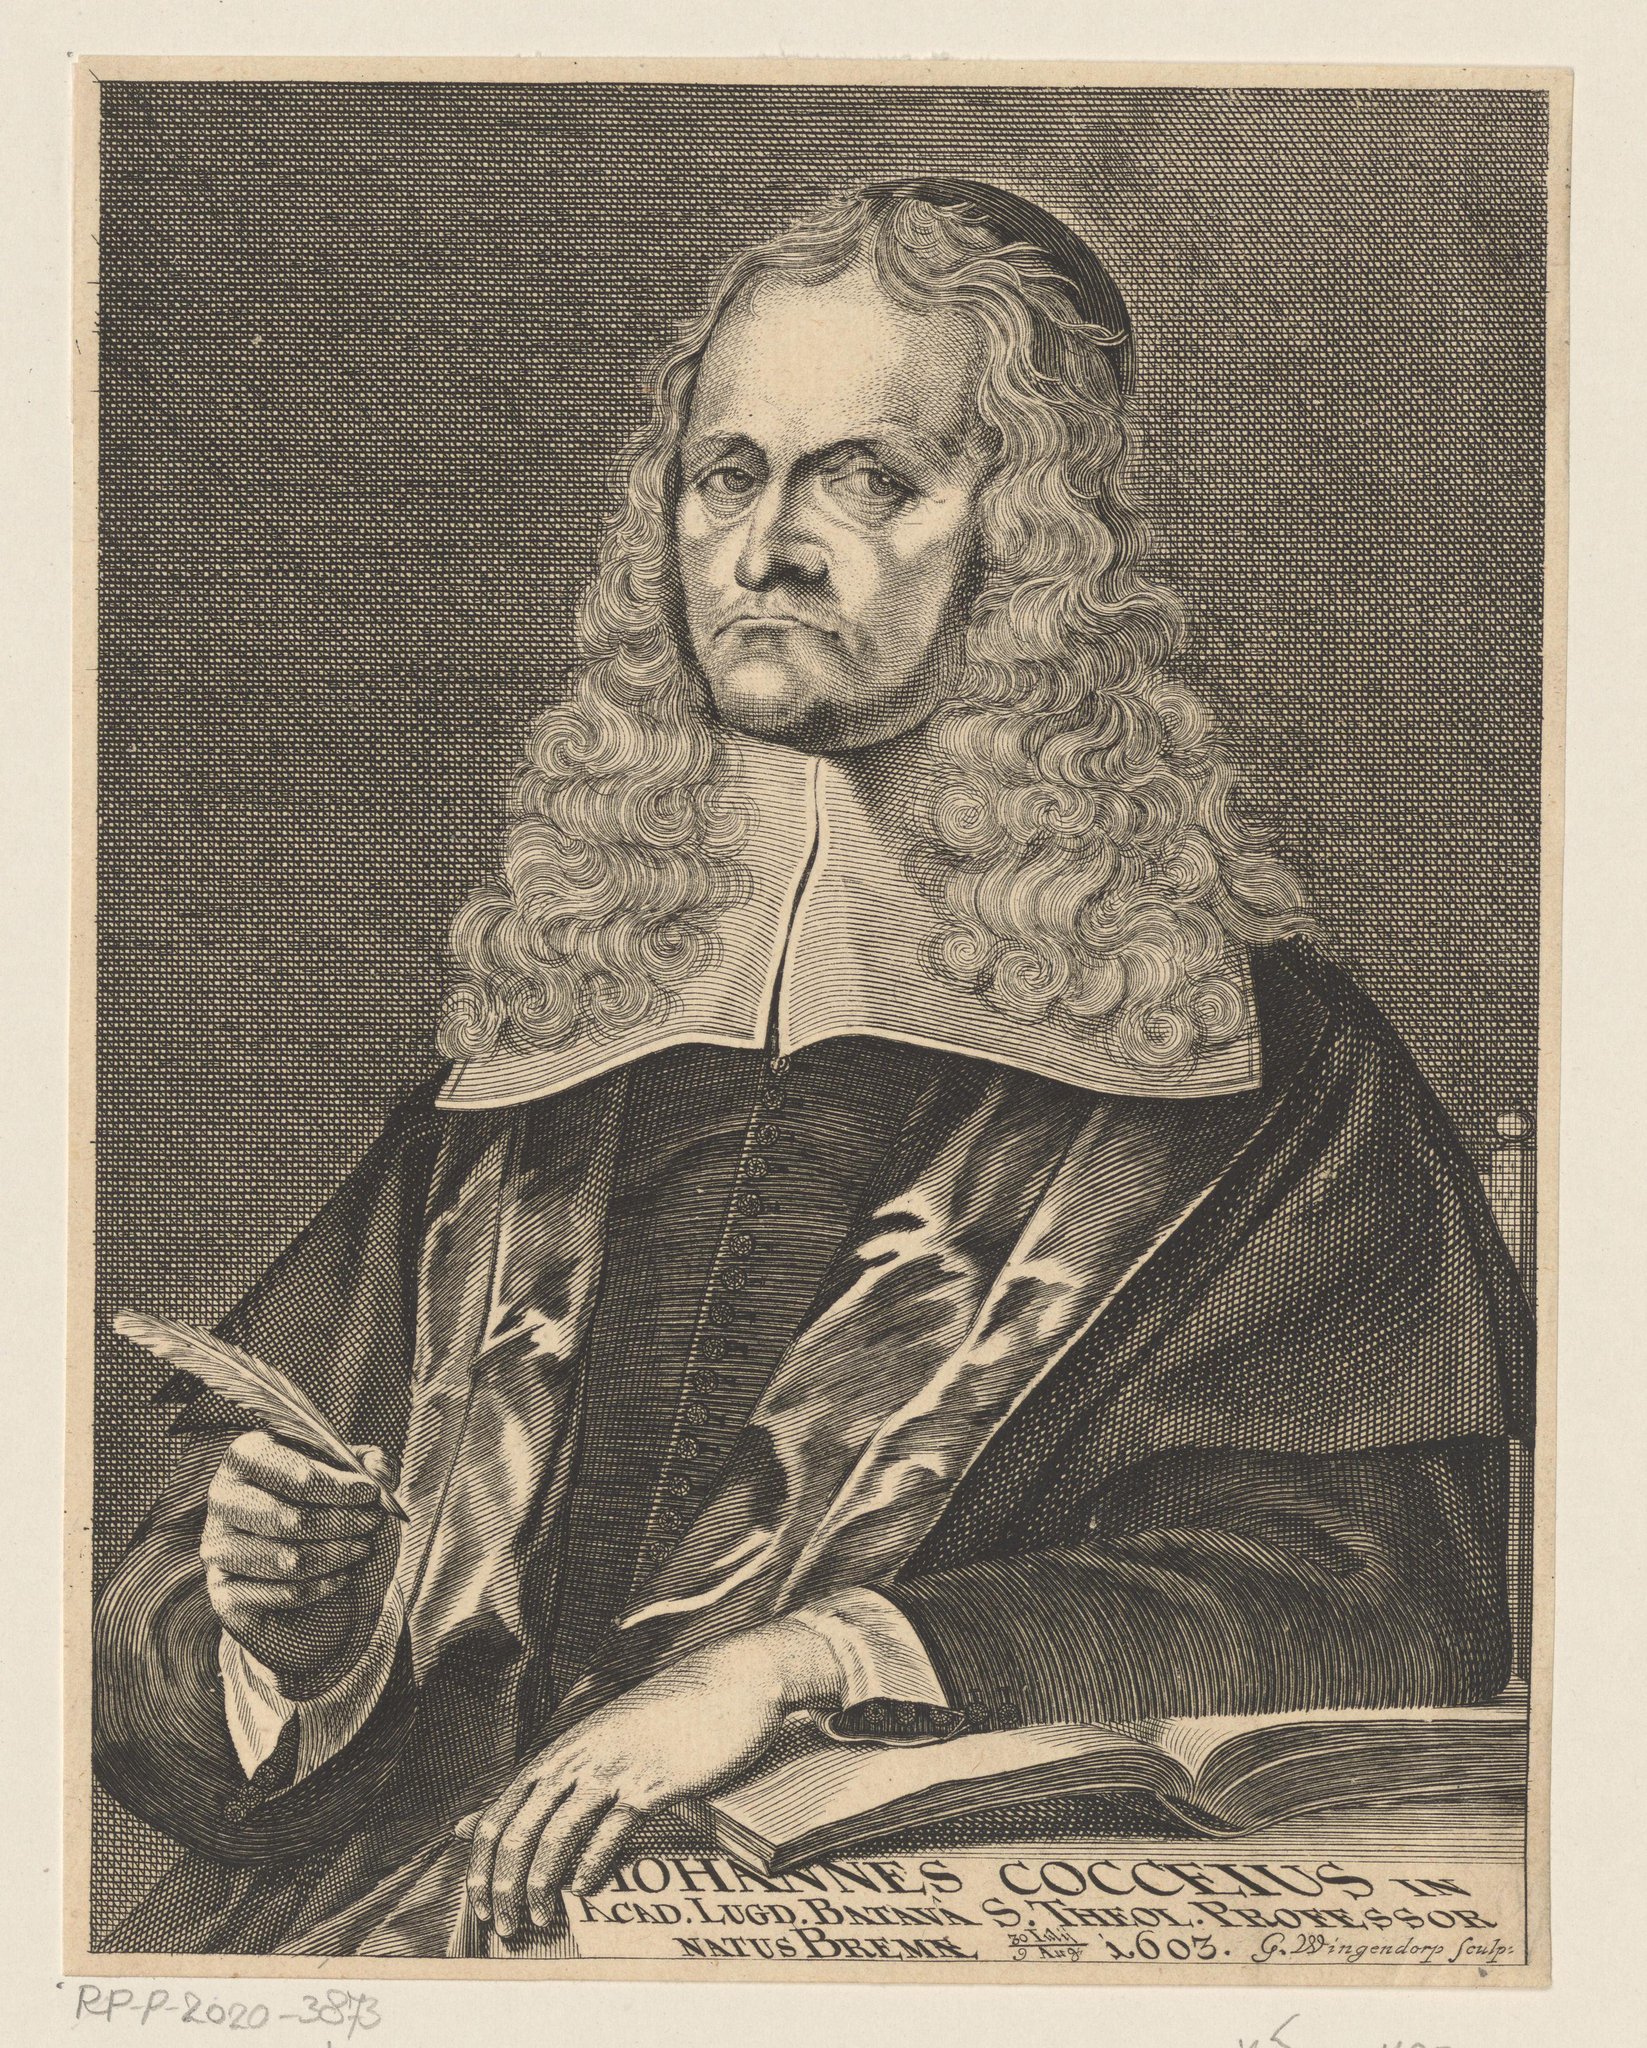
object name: print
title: Portret van Johannes Cocceius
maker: g. wingendorp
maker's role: print maker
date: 1654-1681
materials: paper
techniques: engraving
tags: historical persons